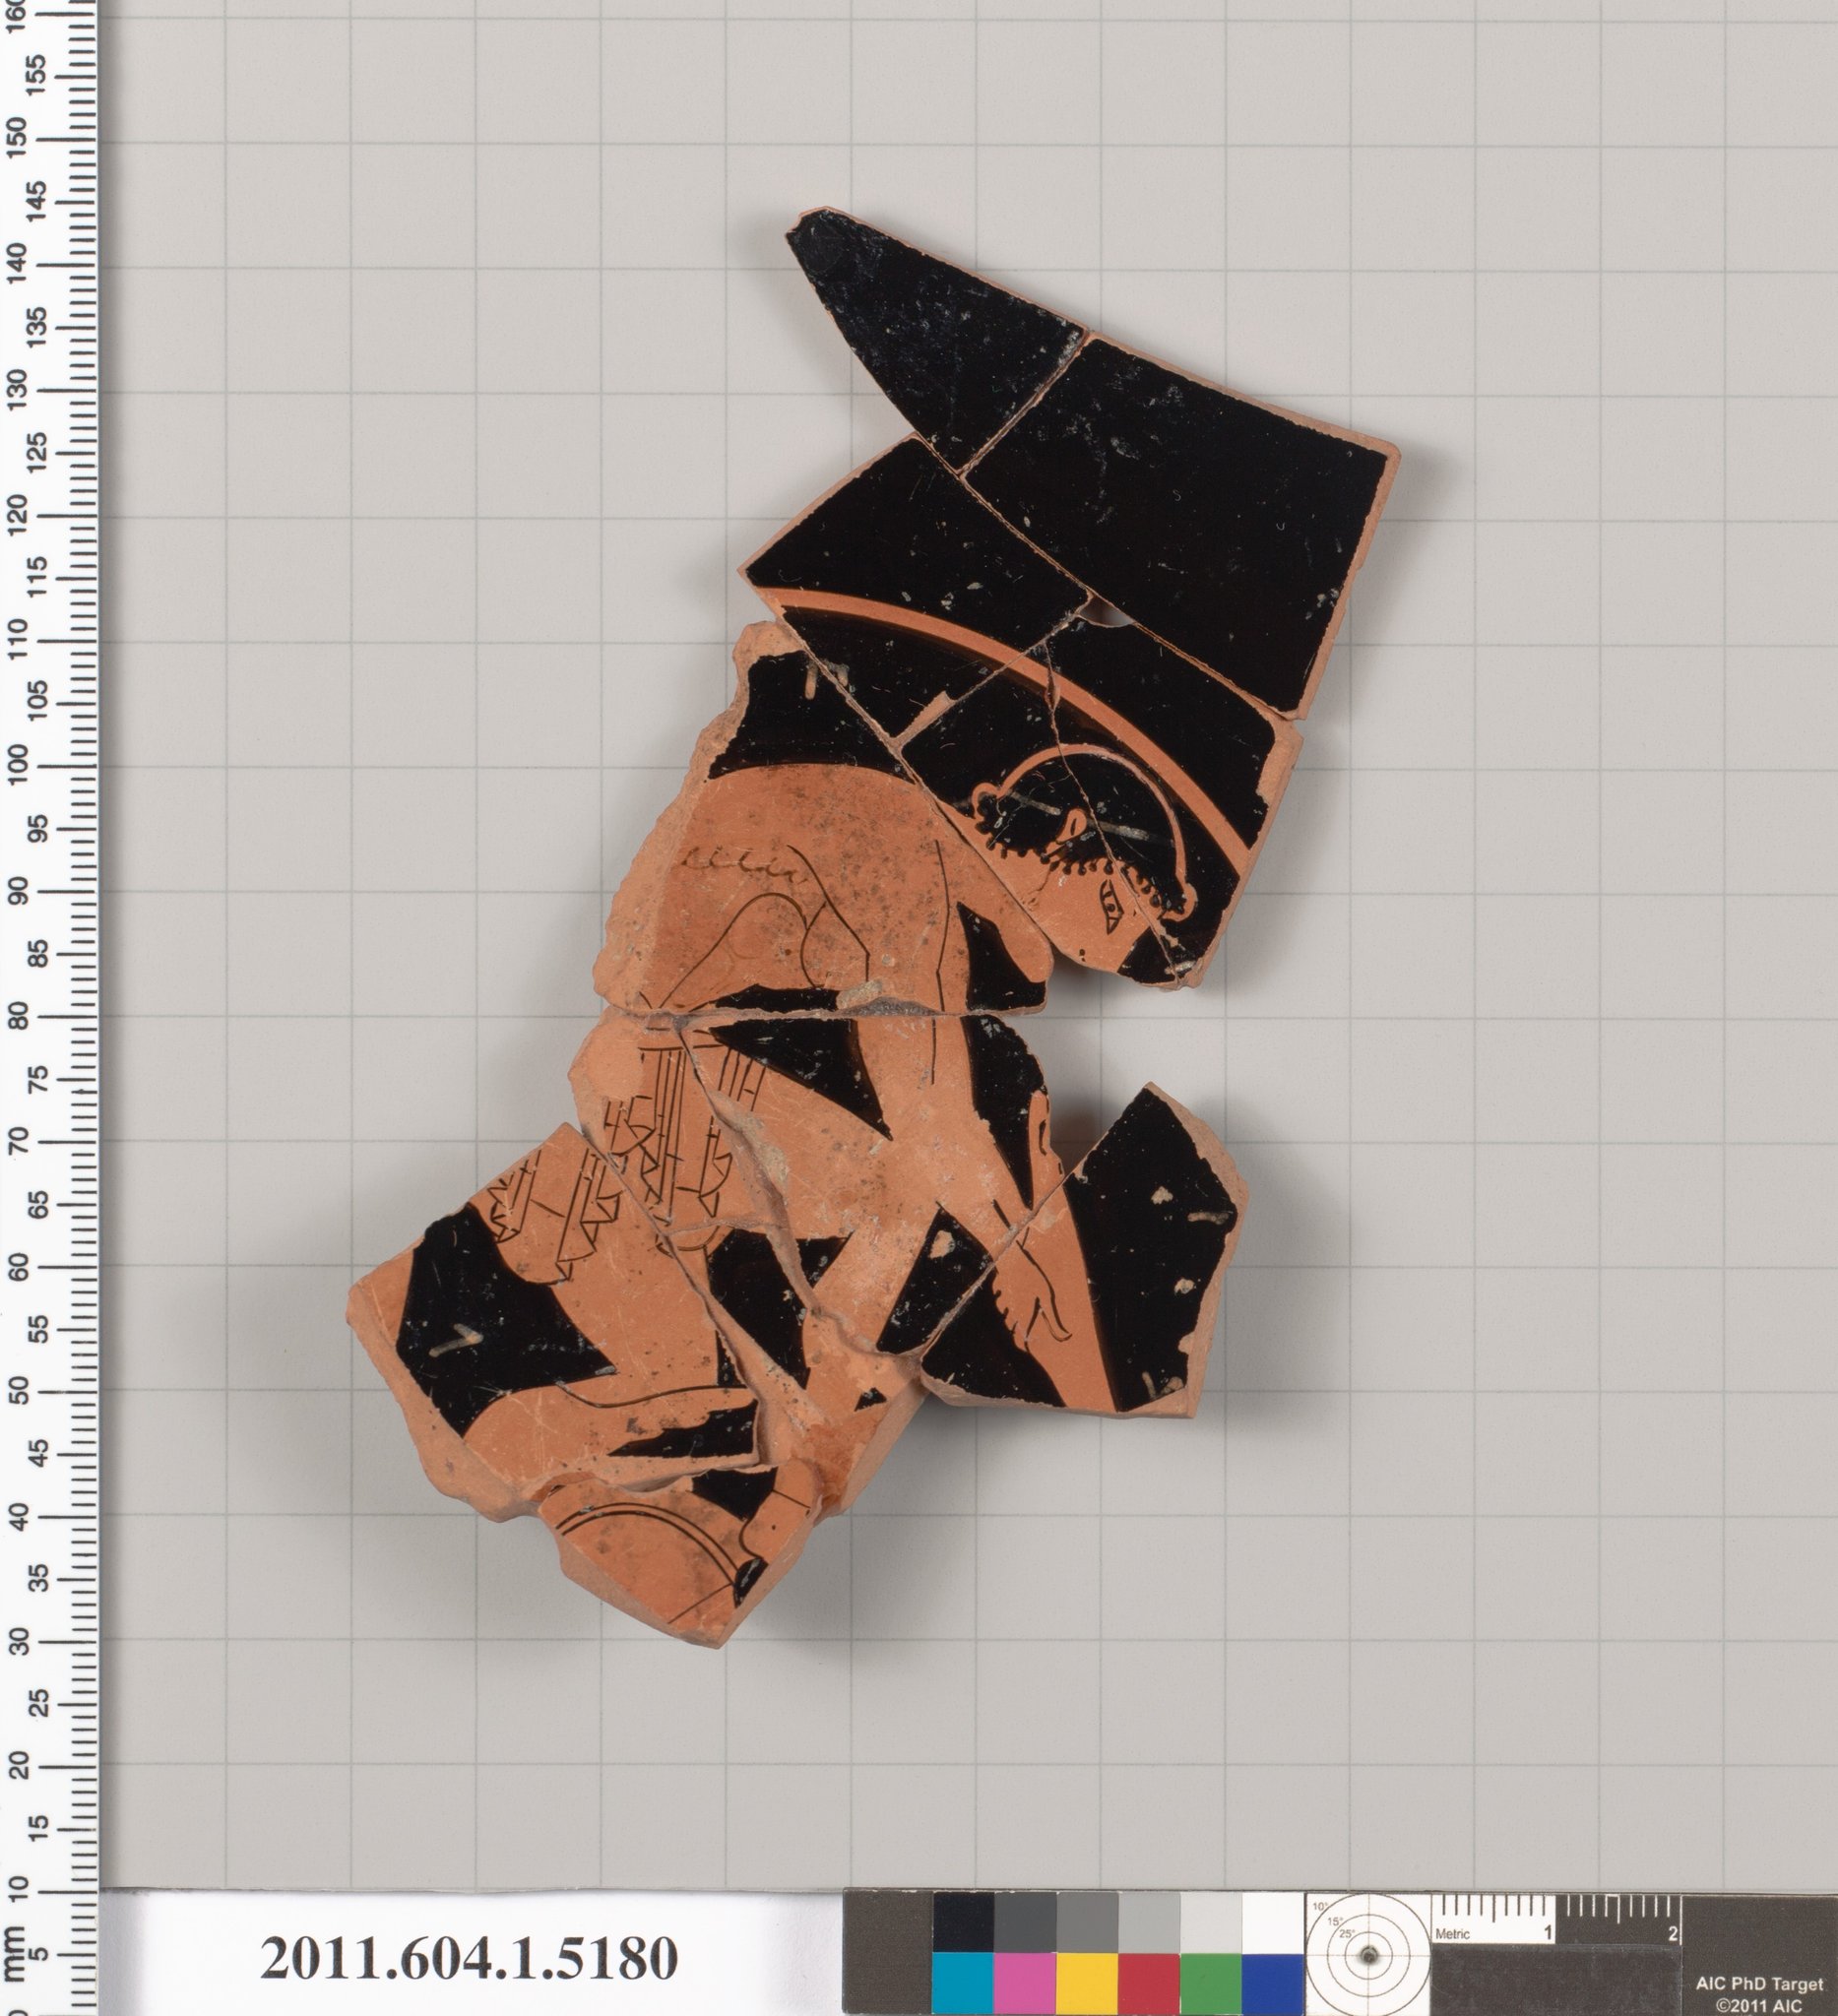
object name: kylix fragment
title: Terracotta fragment of a kylix (drinking cup)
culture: greek, attic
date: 520-500 BCE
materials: terracotta